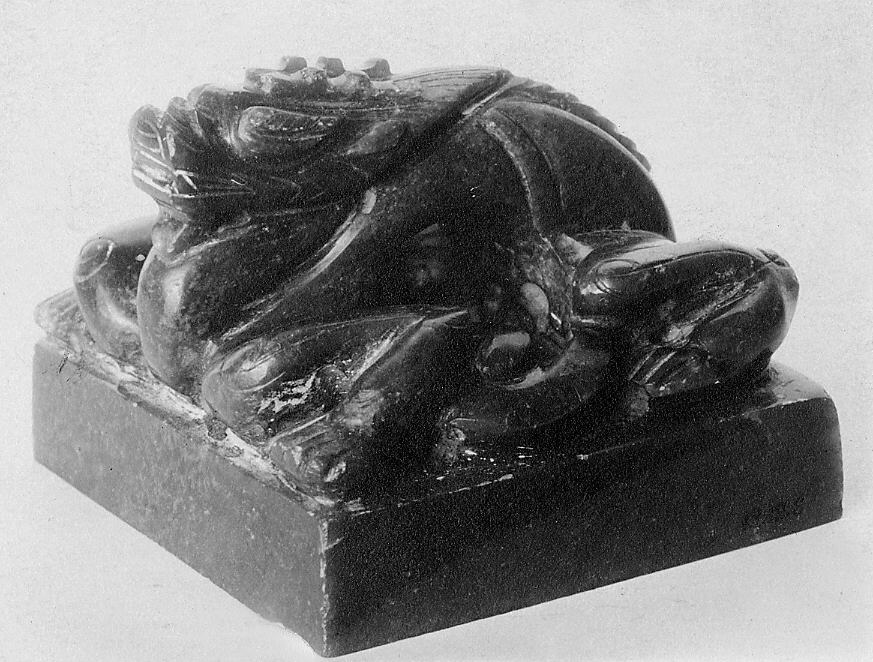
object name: seal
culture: chinese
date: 960-1279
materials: jade